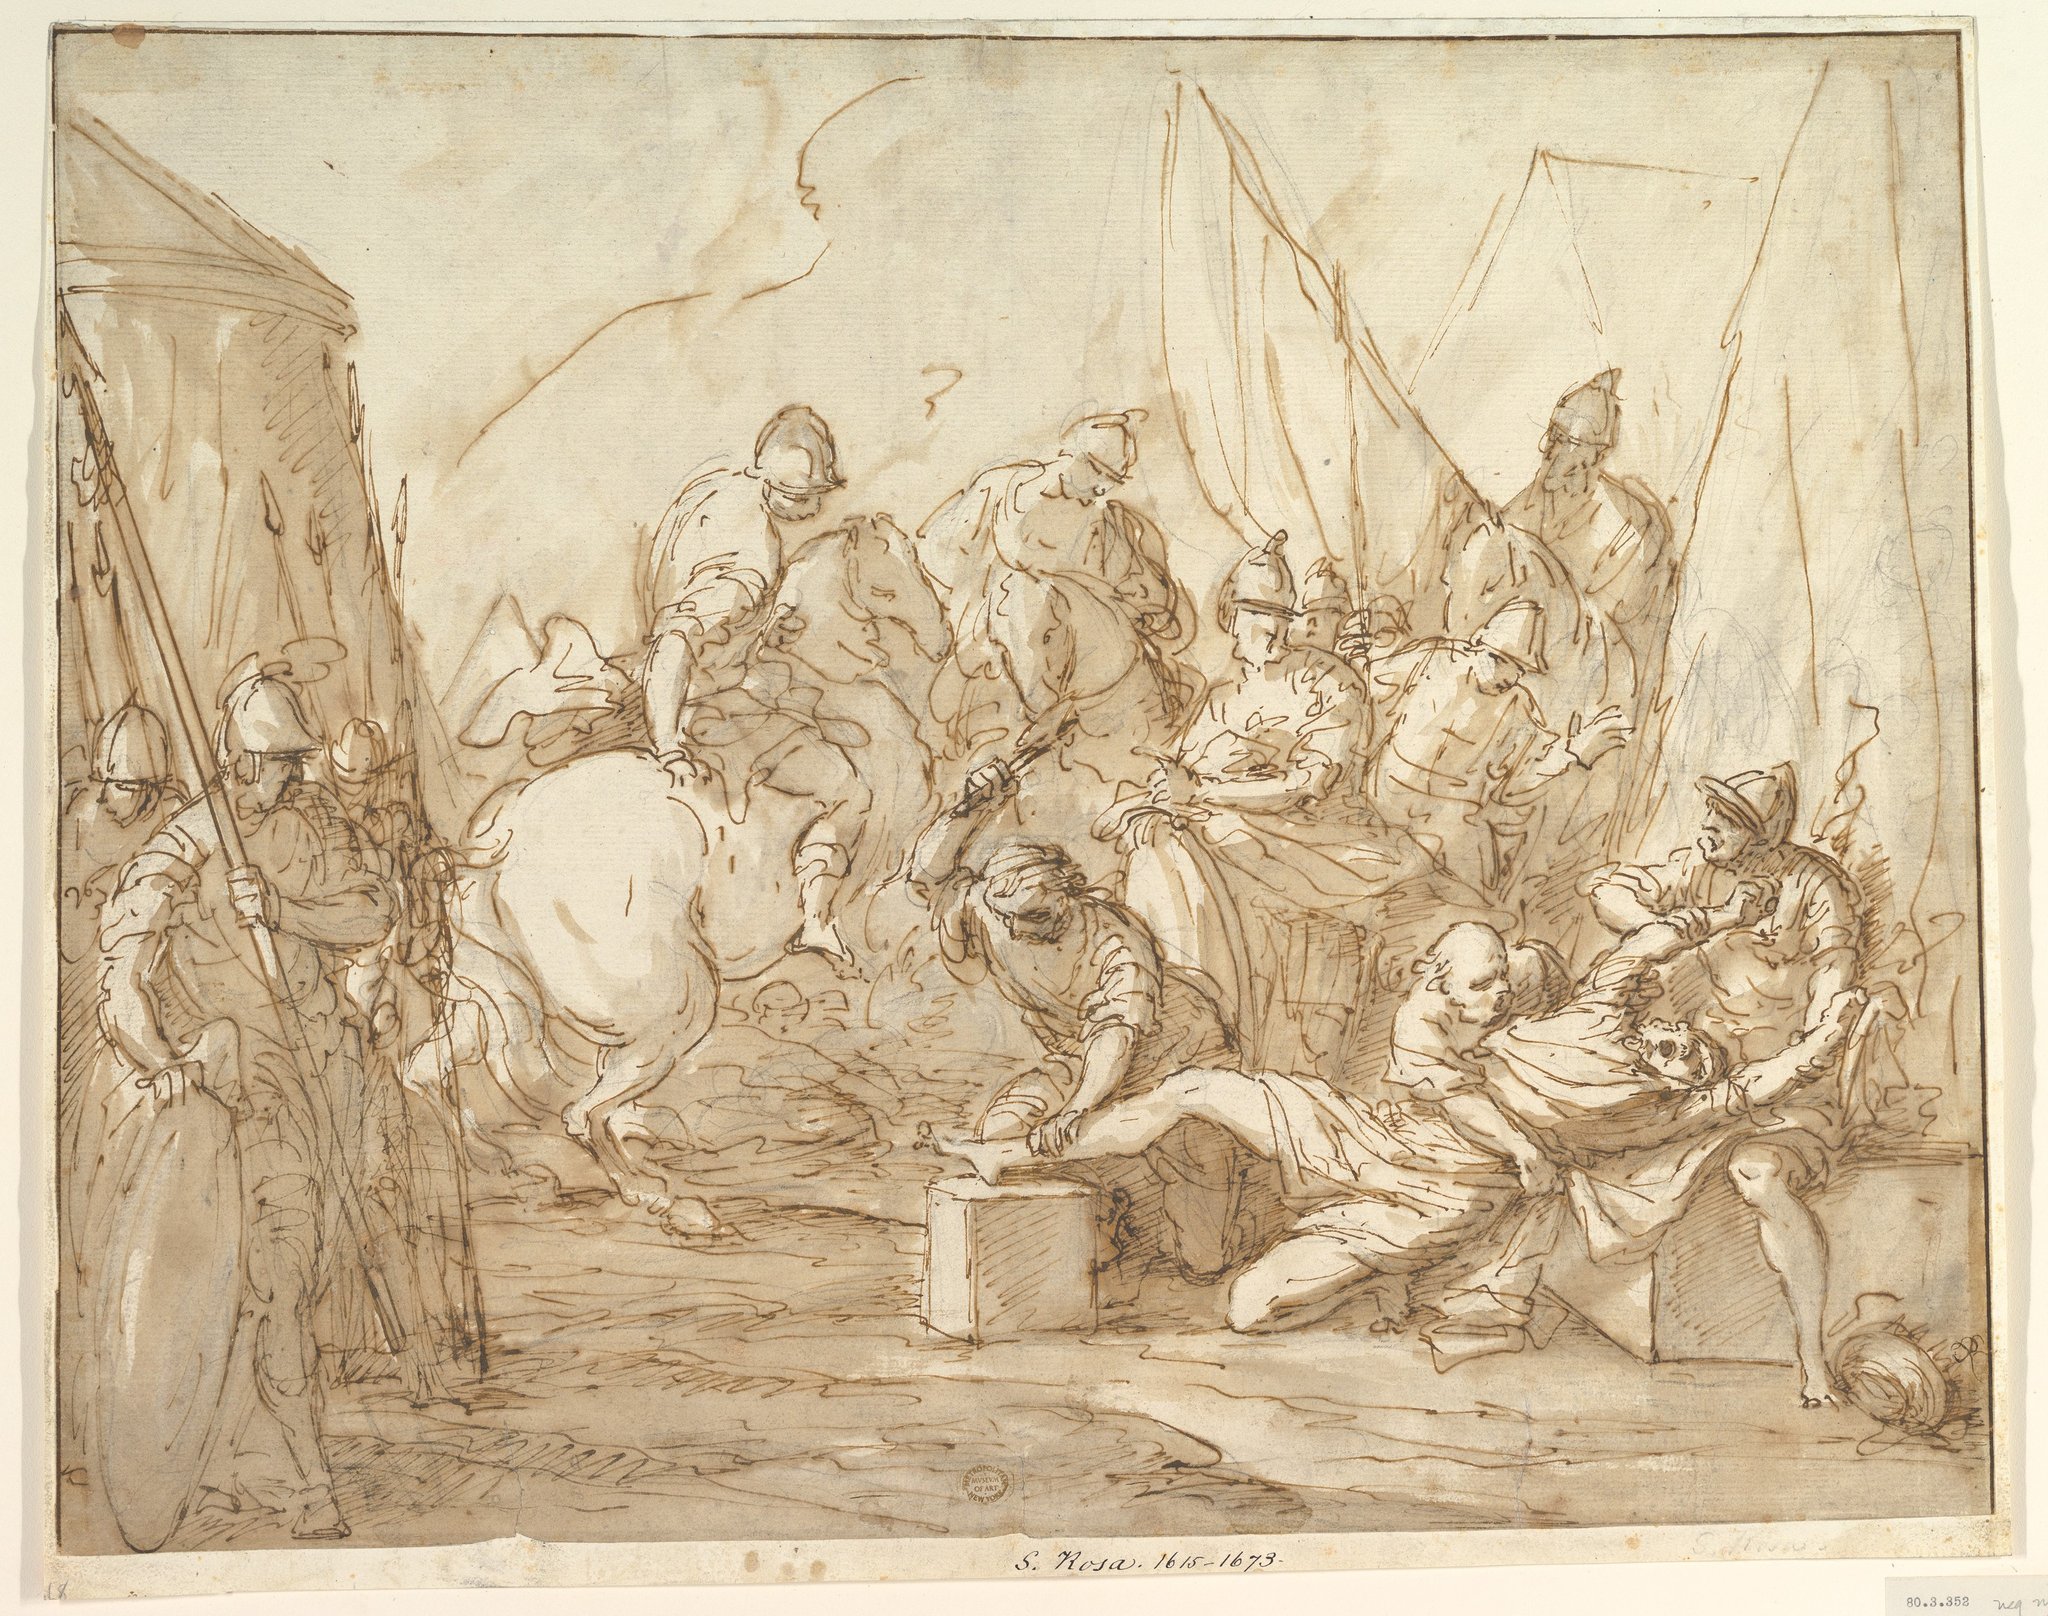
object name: drawing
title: Scene from Ancient History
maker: giuseppe piattoli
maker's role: artist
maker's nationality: italian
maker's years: 1785-1807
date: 1785-1807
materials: chalk, ink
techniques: brush, pen, wash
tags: tents,soldiers,spears,men,horses